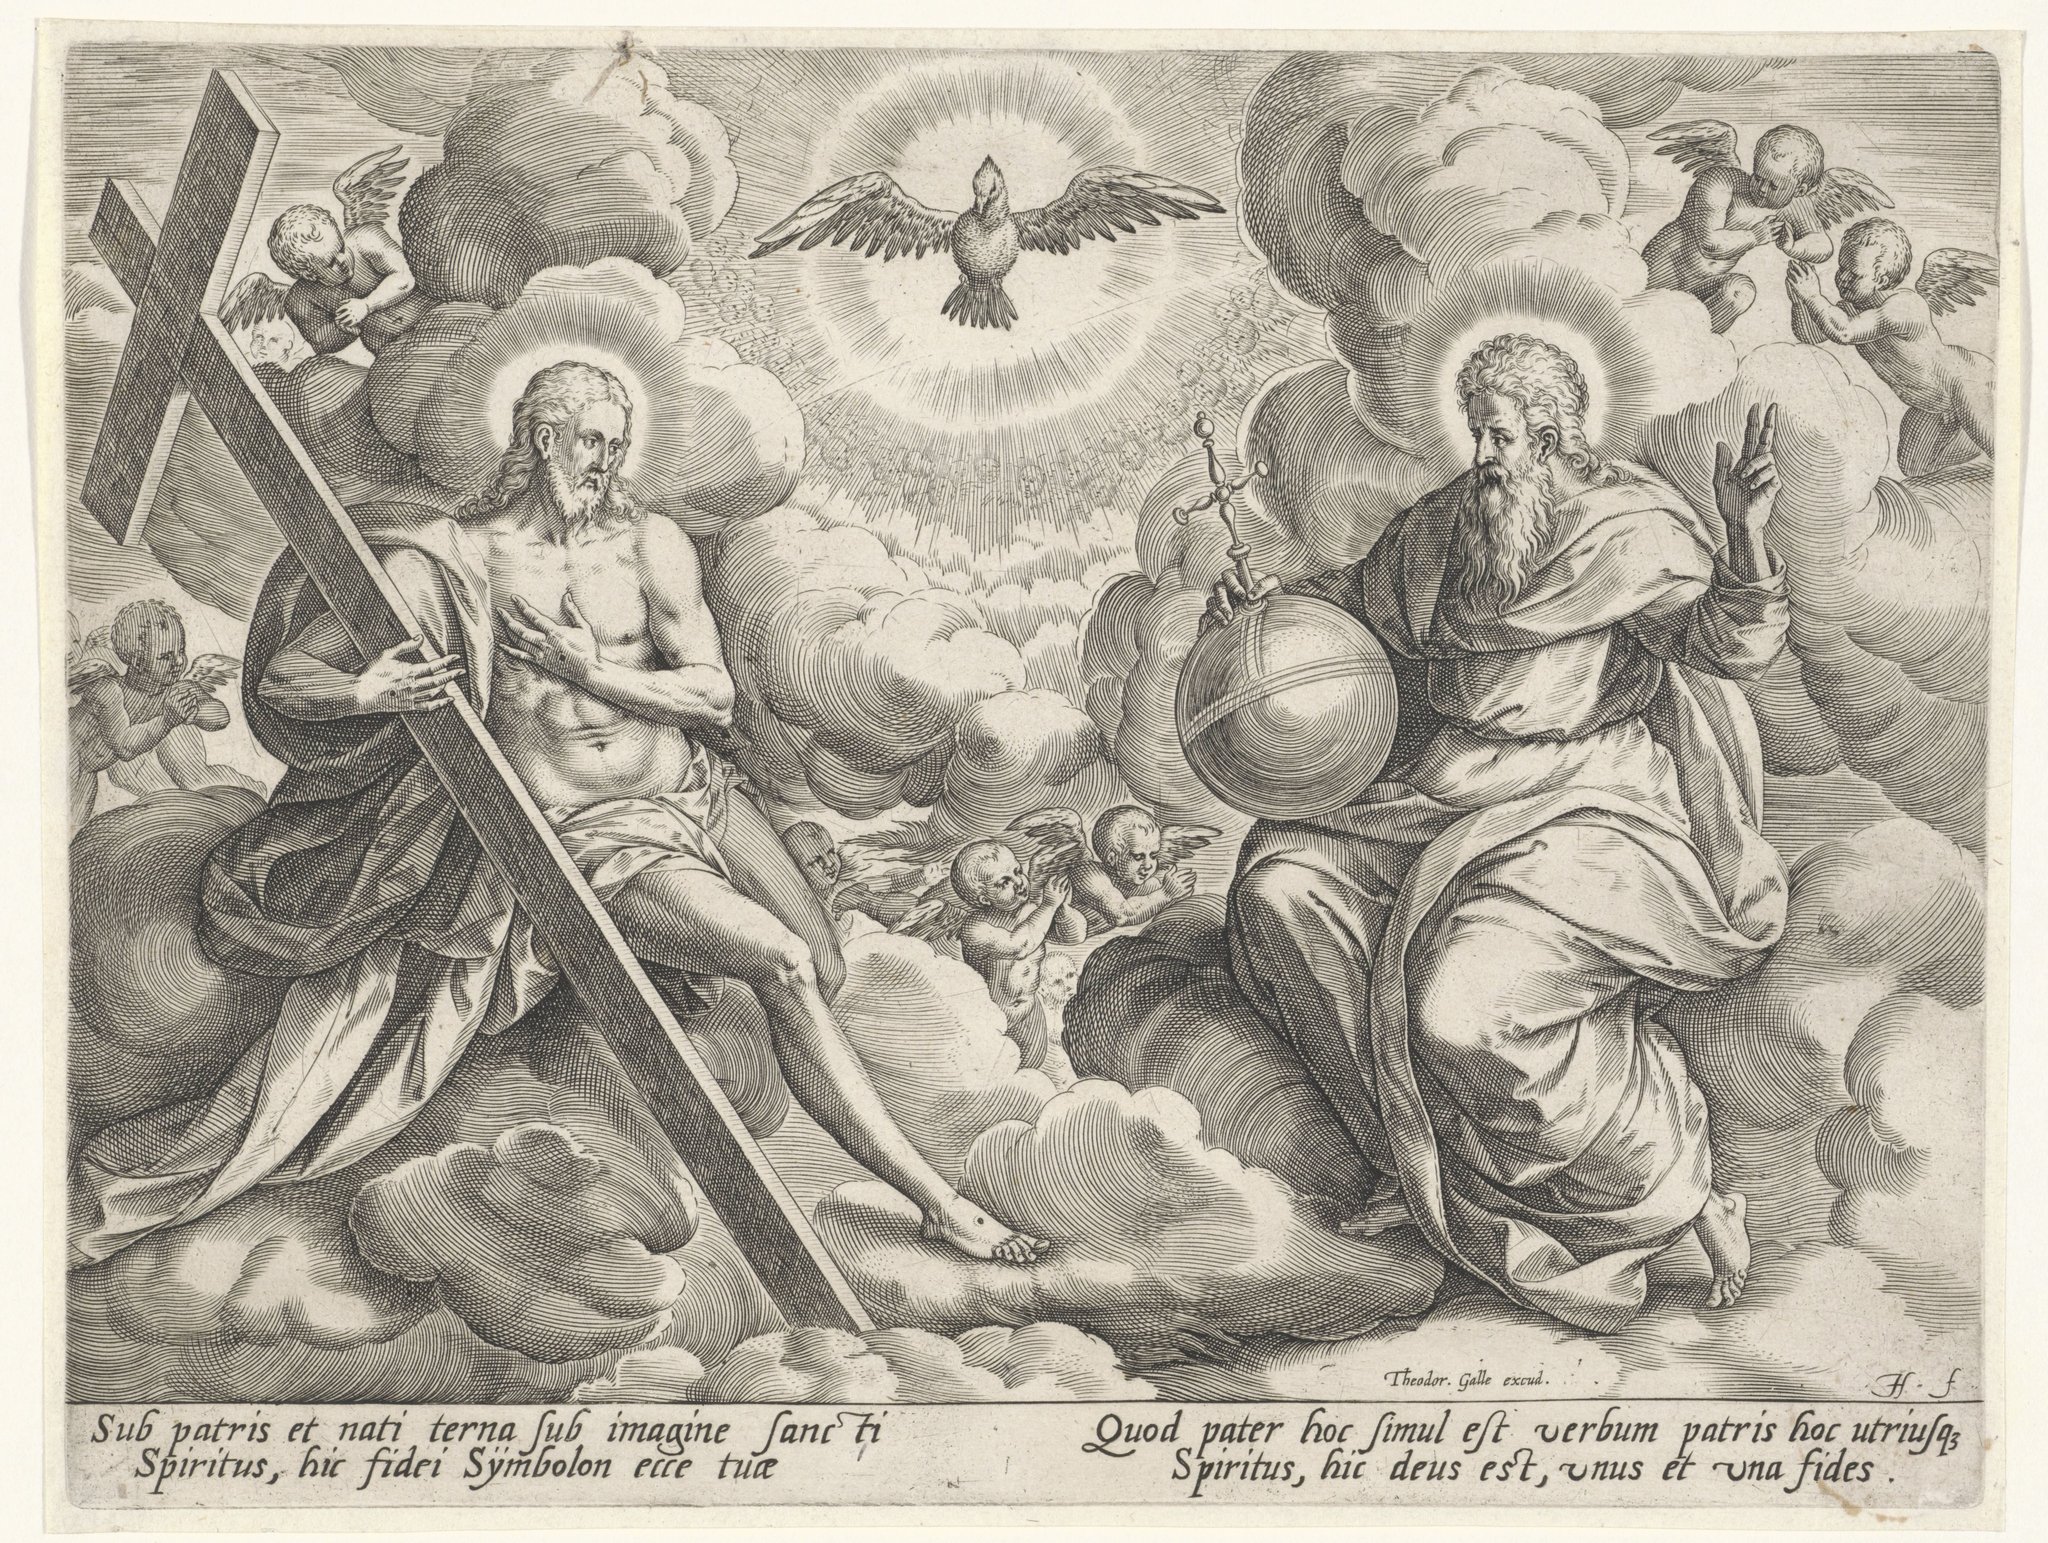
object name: print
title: De heilige Drieëenheid in de wolken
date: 1560-1591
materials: paper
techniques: engraving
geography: antwerp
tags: trinity in which god the father and christ are represented as persons, the holy ghost as dove (+ angel(s))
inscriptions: collector's mark: Lugt 240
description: De heilige Drieëenheid in de wolken. Links Christus met het kruis in zijn linkerhand. Rechts God de Vader met de rijksappel. in het midden de Heilige Geest als duif. Rondom hen biddende engelen.